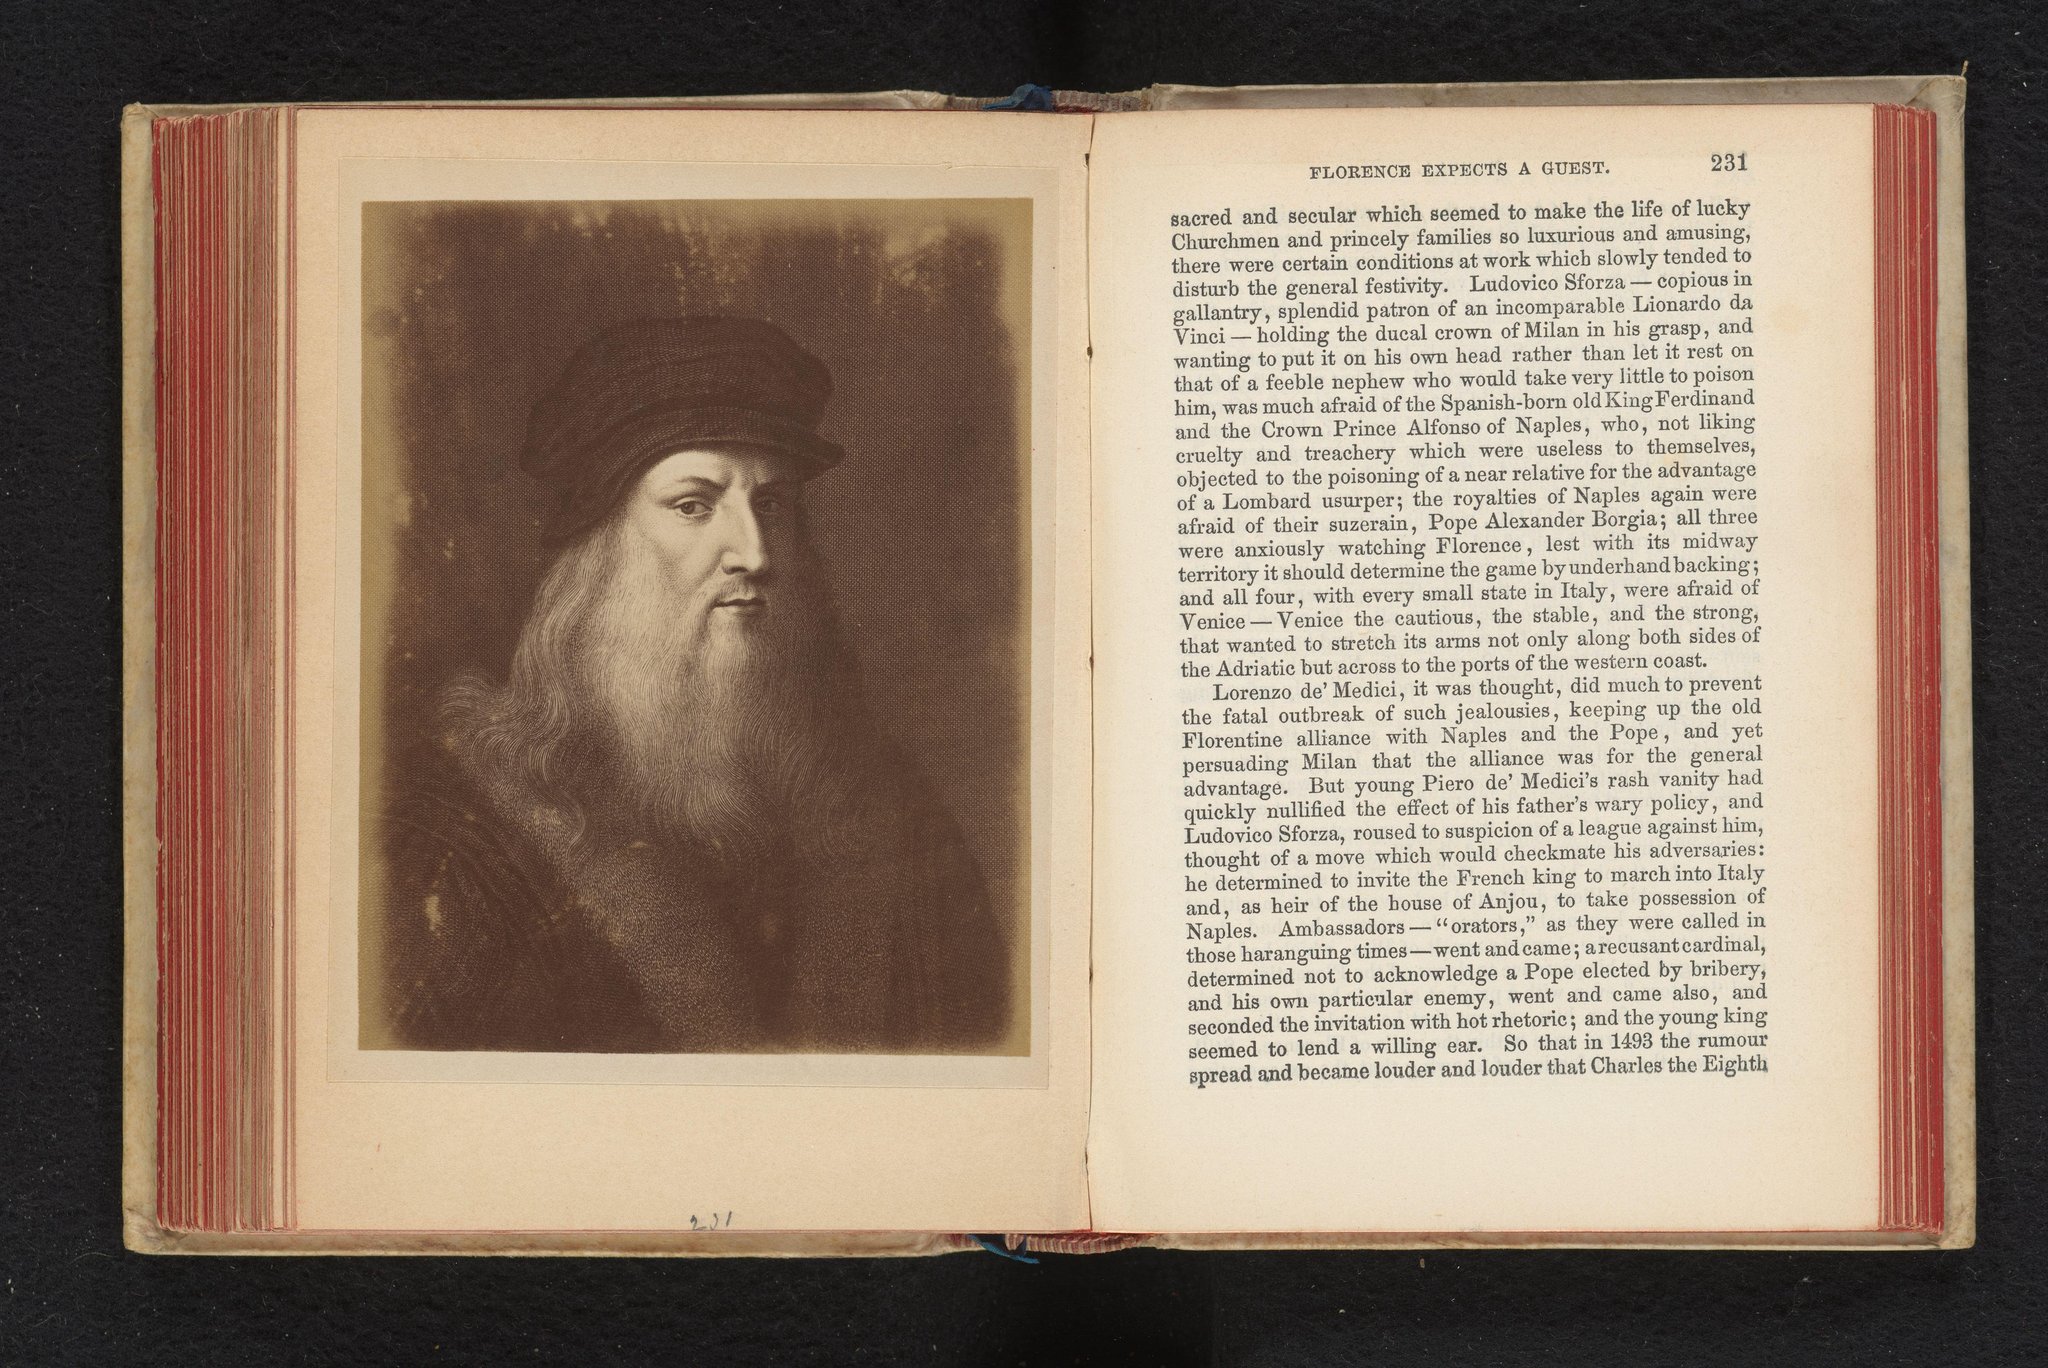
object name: reproduction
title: Fotoreproductie van een prent van een portret van Leonardo da Vinci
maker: giacomo brogi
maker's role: fotograaf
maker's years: 1822-1881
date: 1858-1863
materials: paper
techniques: albumen print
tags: artist, leonardo da vinci, historical persons, portrait, self-portrait of artist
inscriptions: name: ‘Brogi’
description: Foto op ongenummerde pagina tegenover pagina 231.